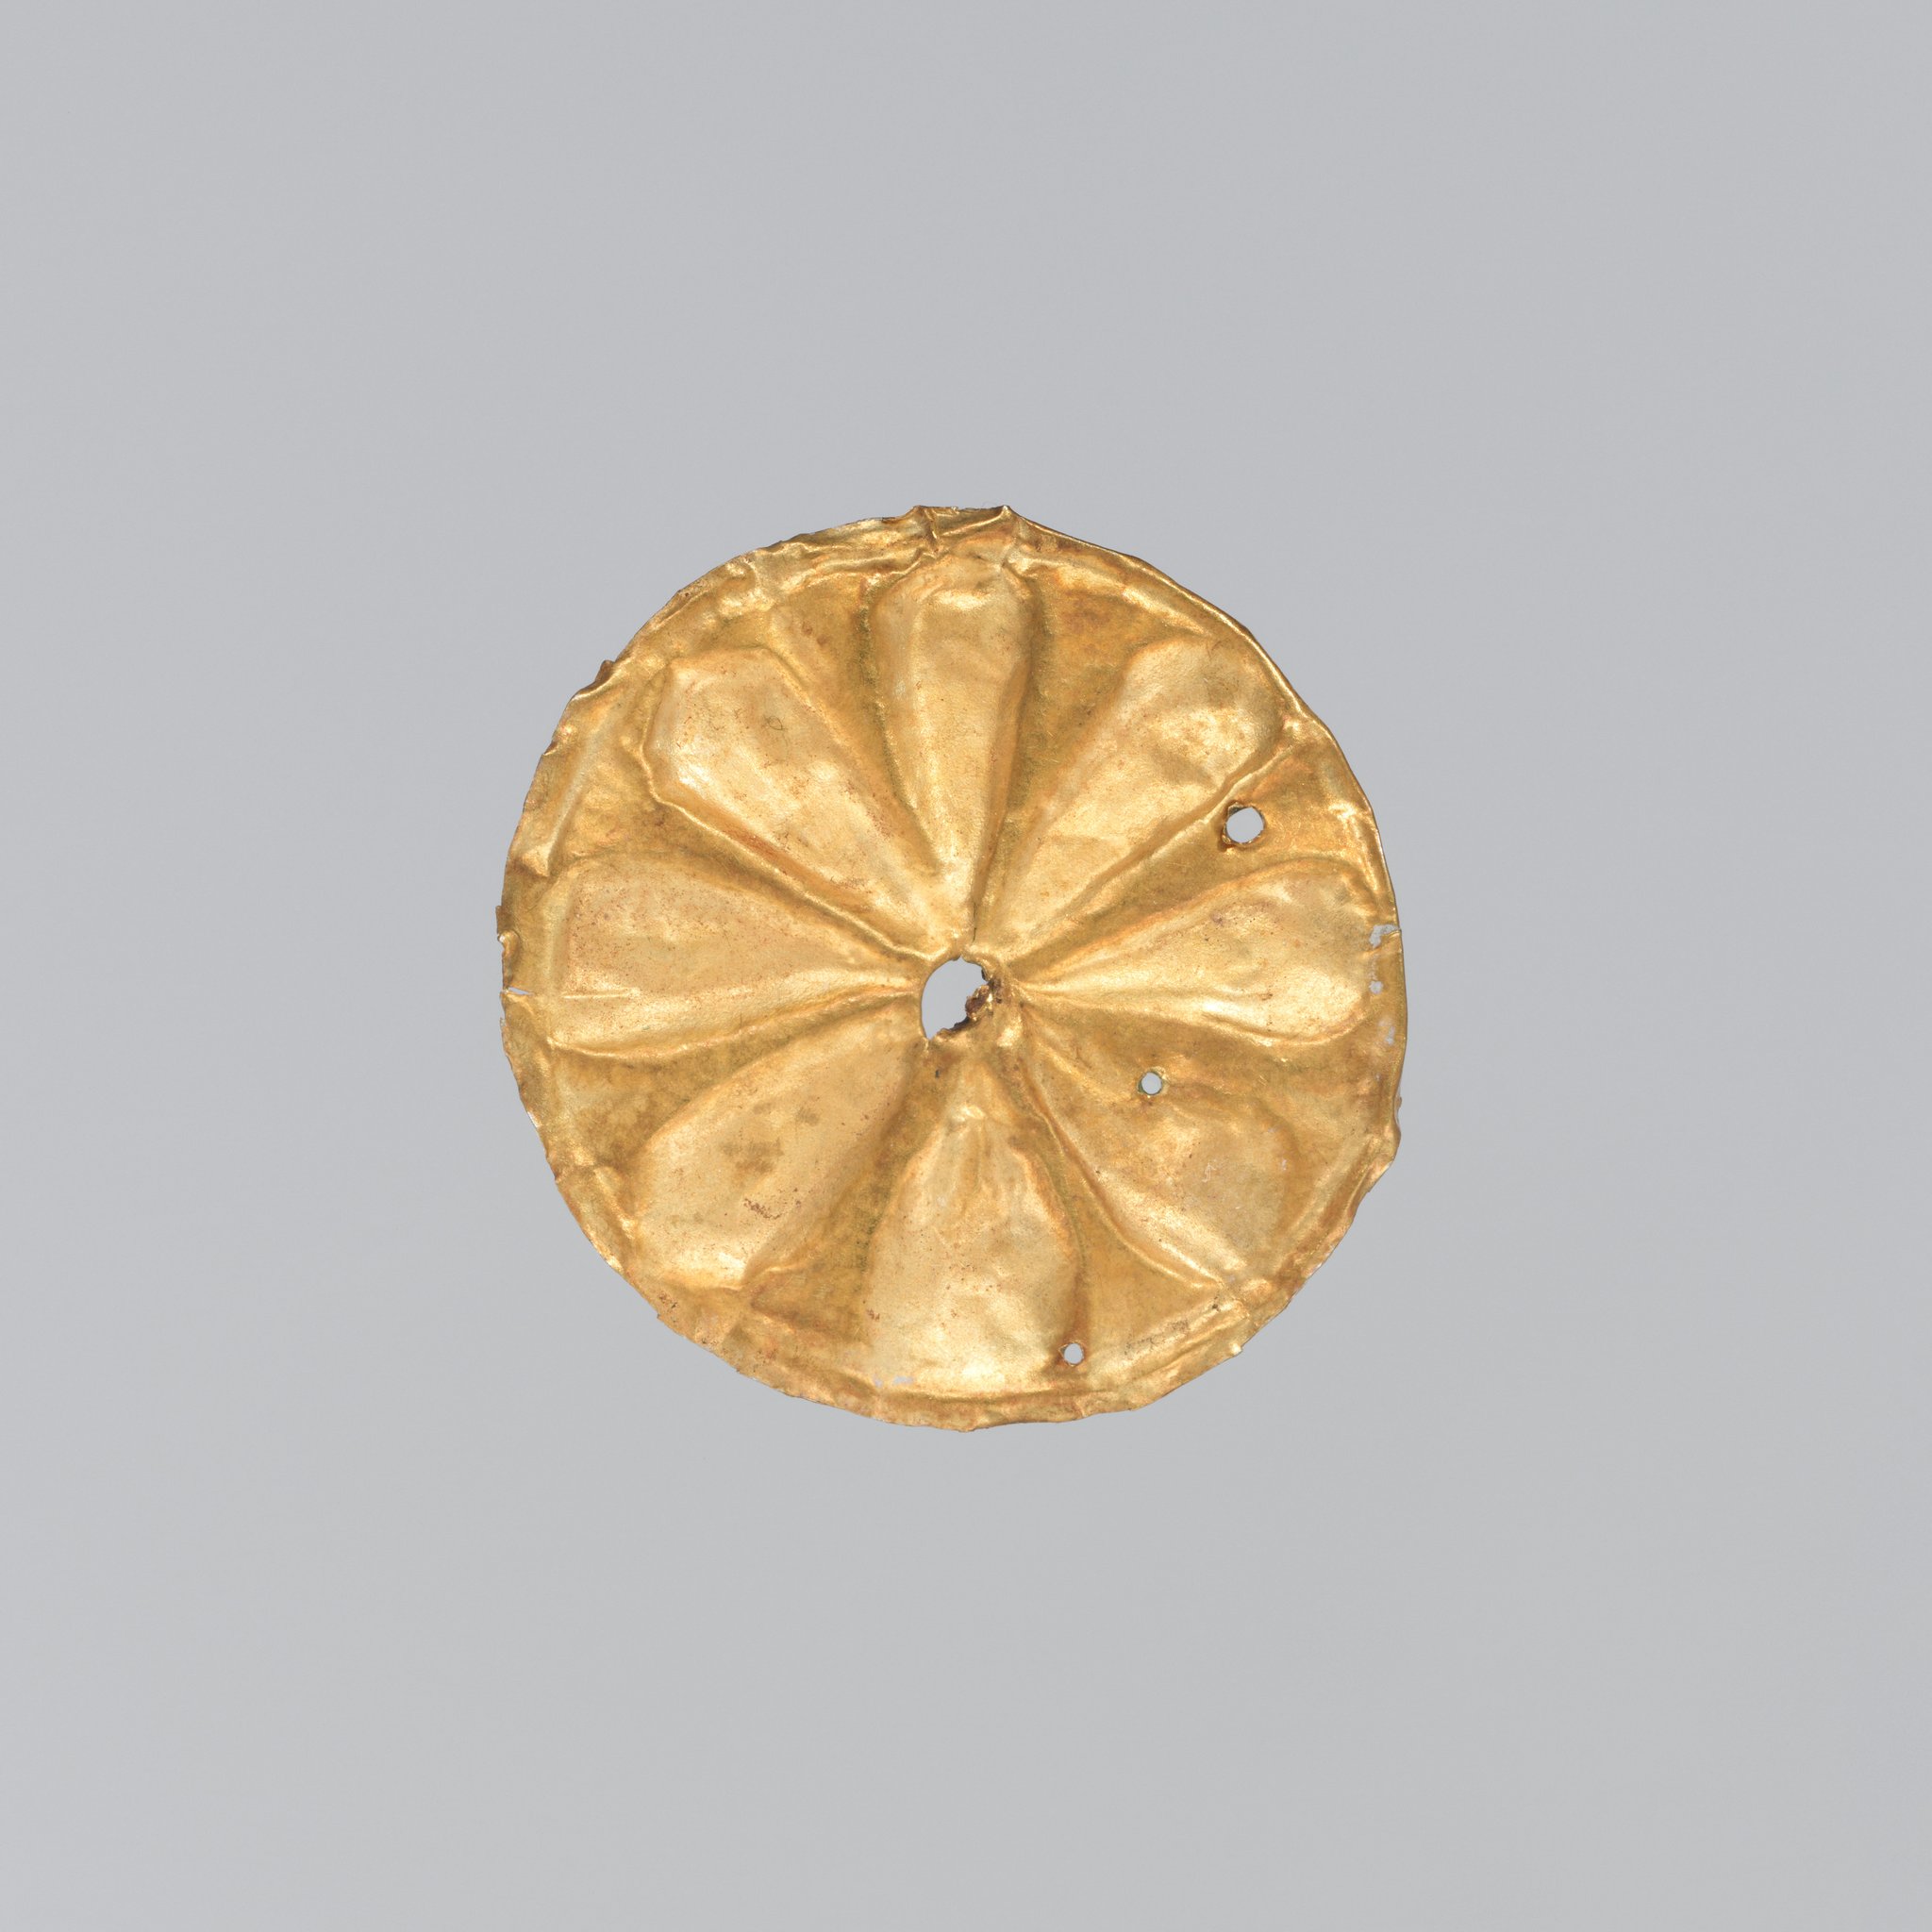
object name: roundel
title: Gold roundel with stamped designs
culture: cypriot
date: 1600-1050 BCE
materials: gold